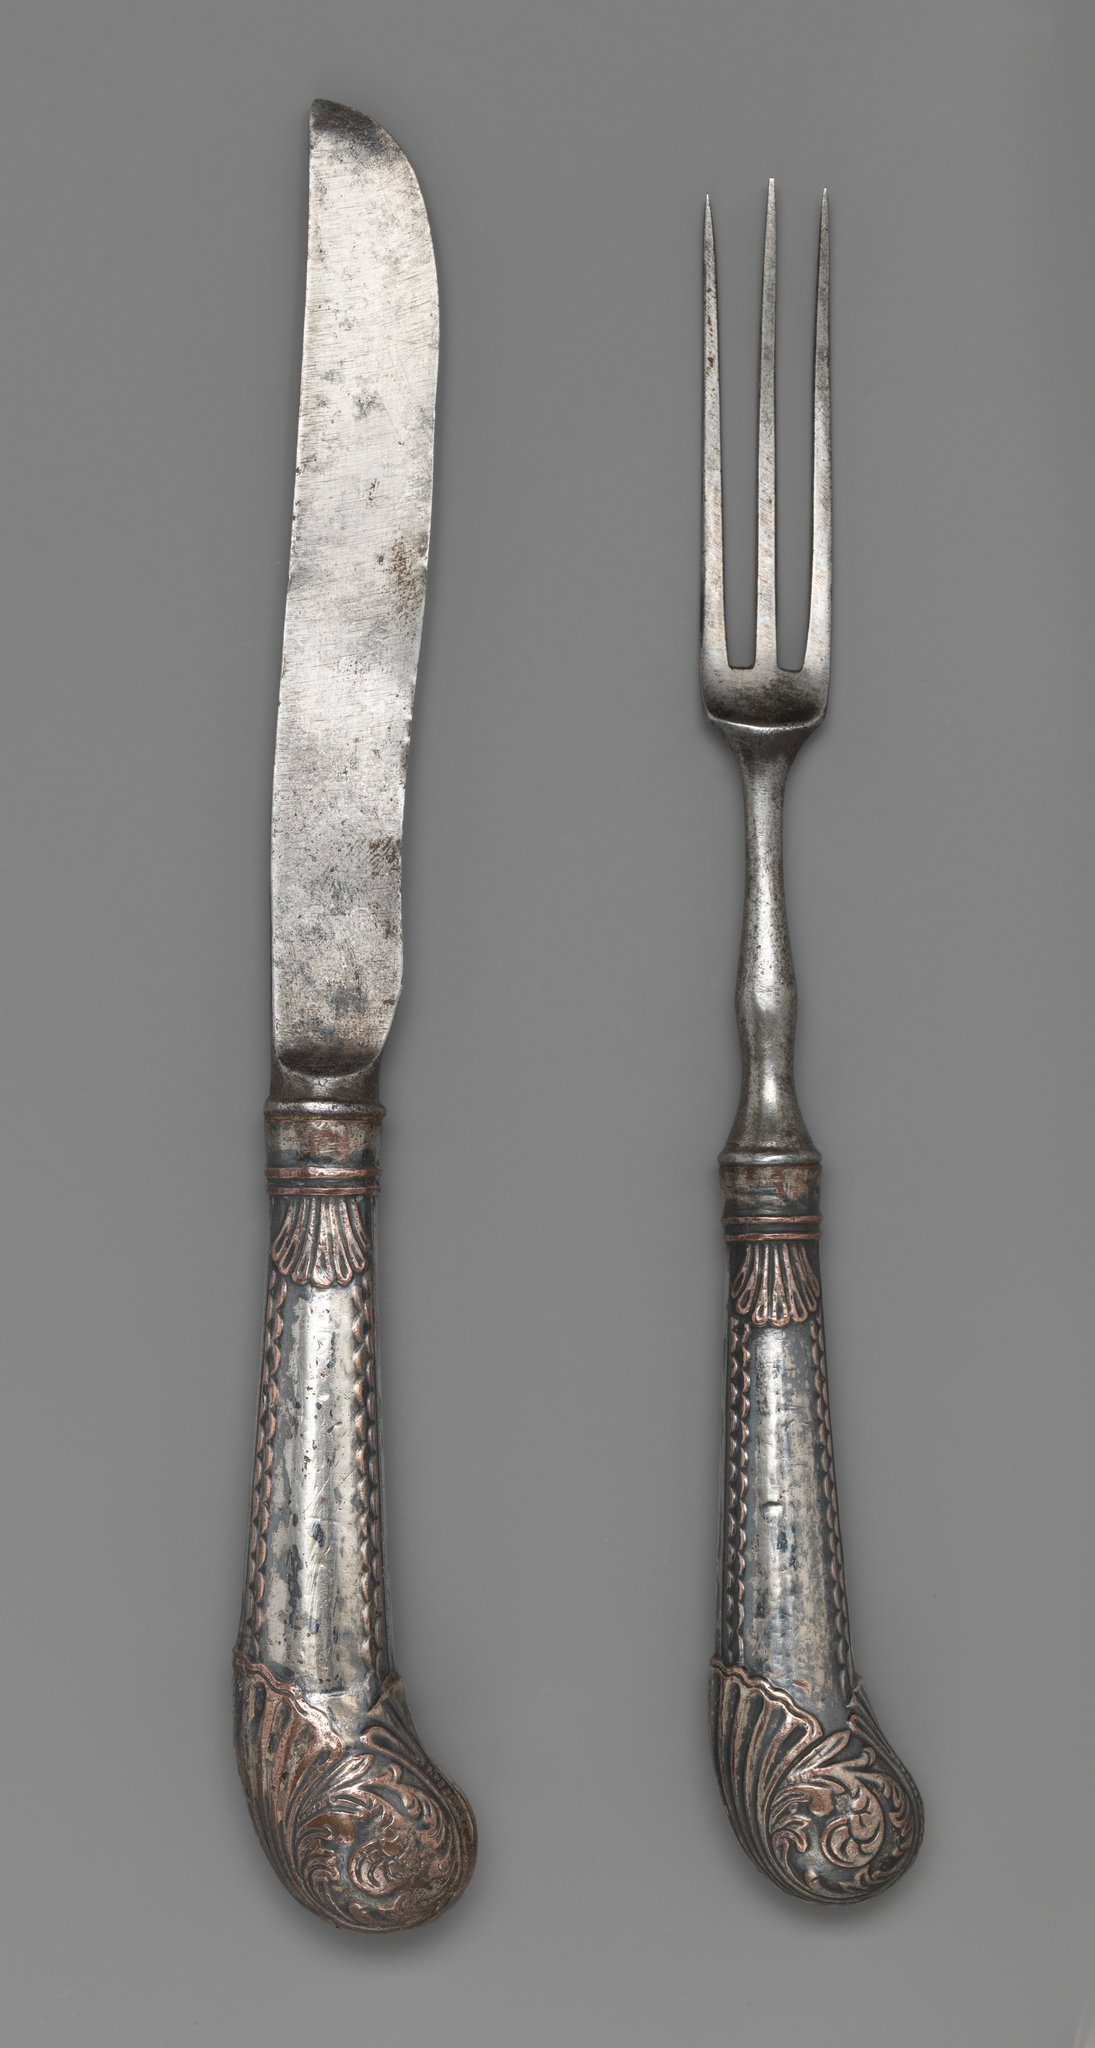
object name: table knife and fork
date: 1701-1800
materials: silver, steel